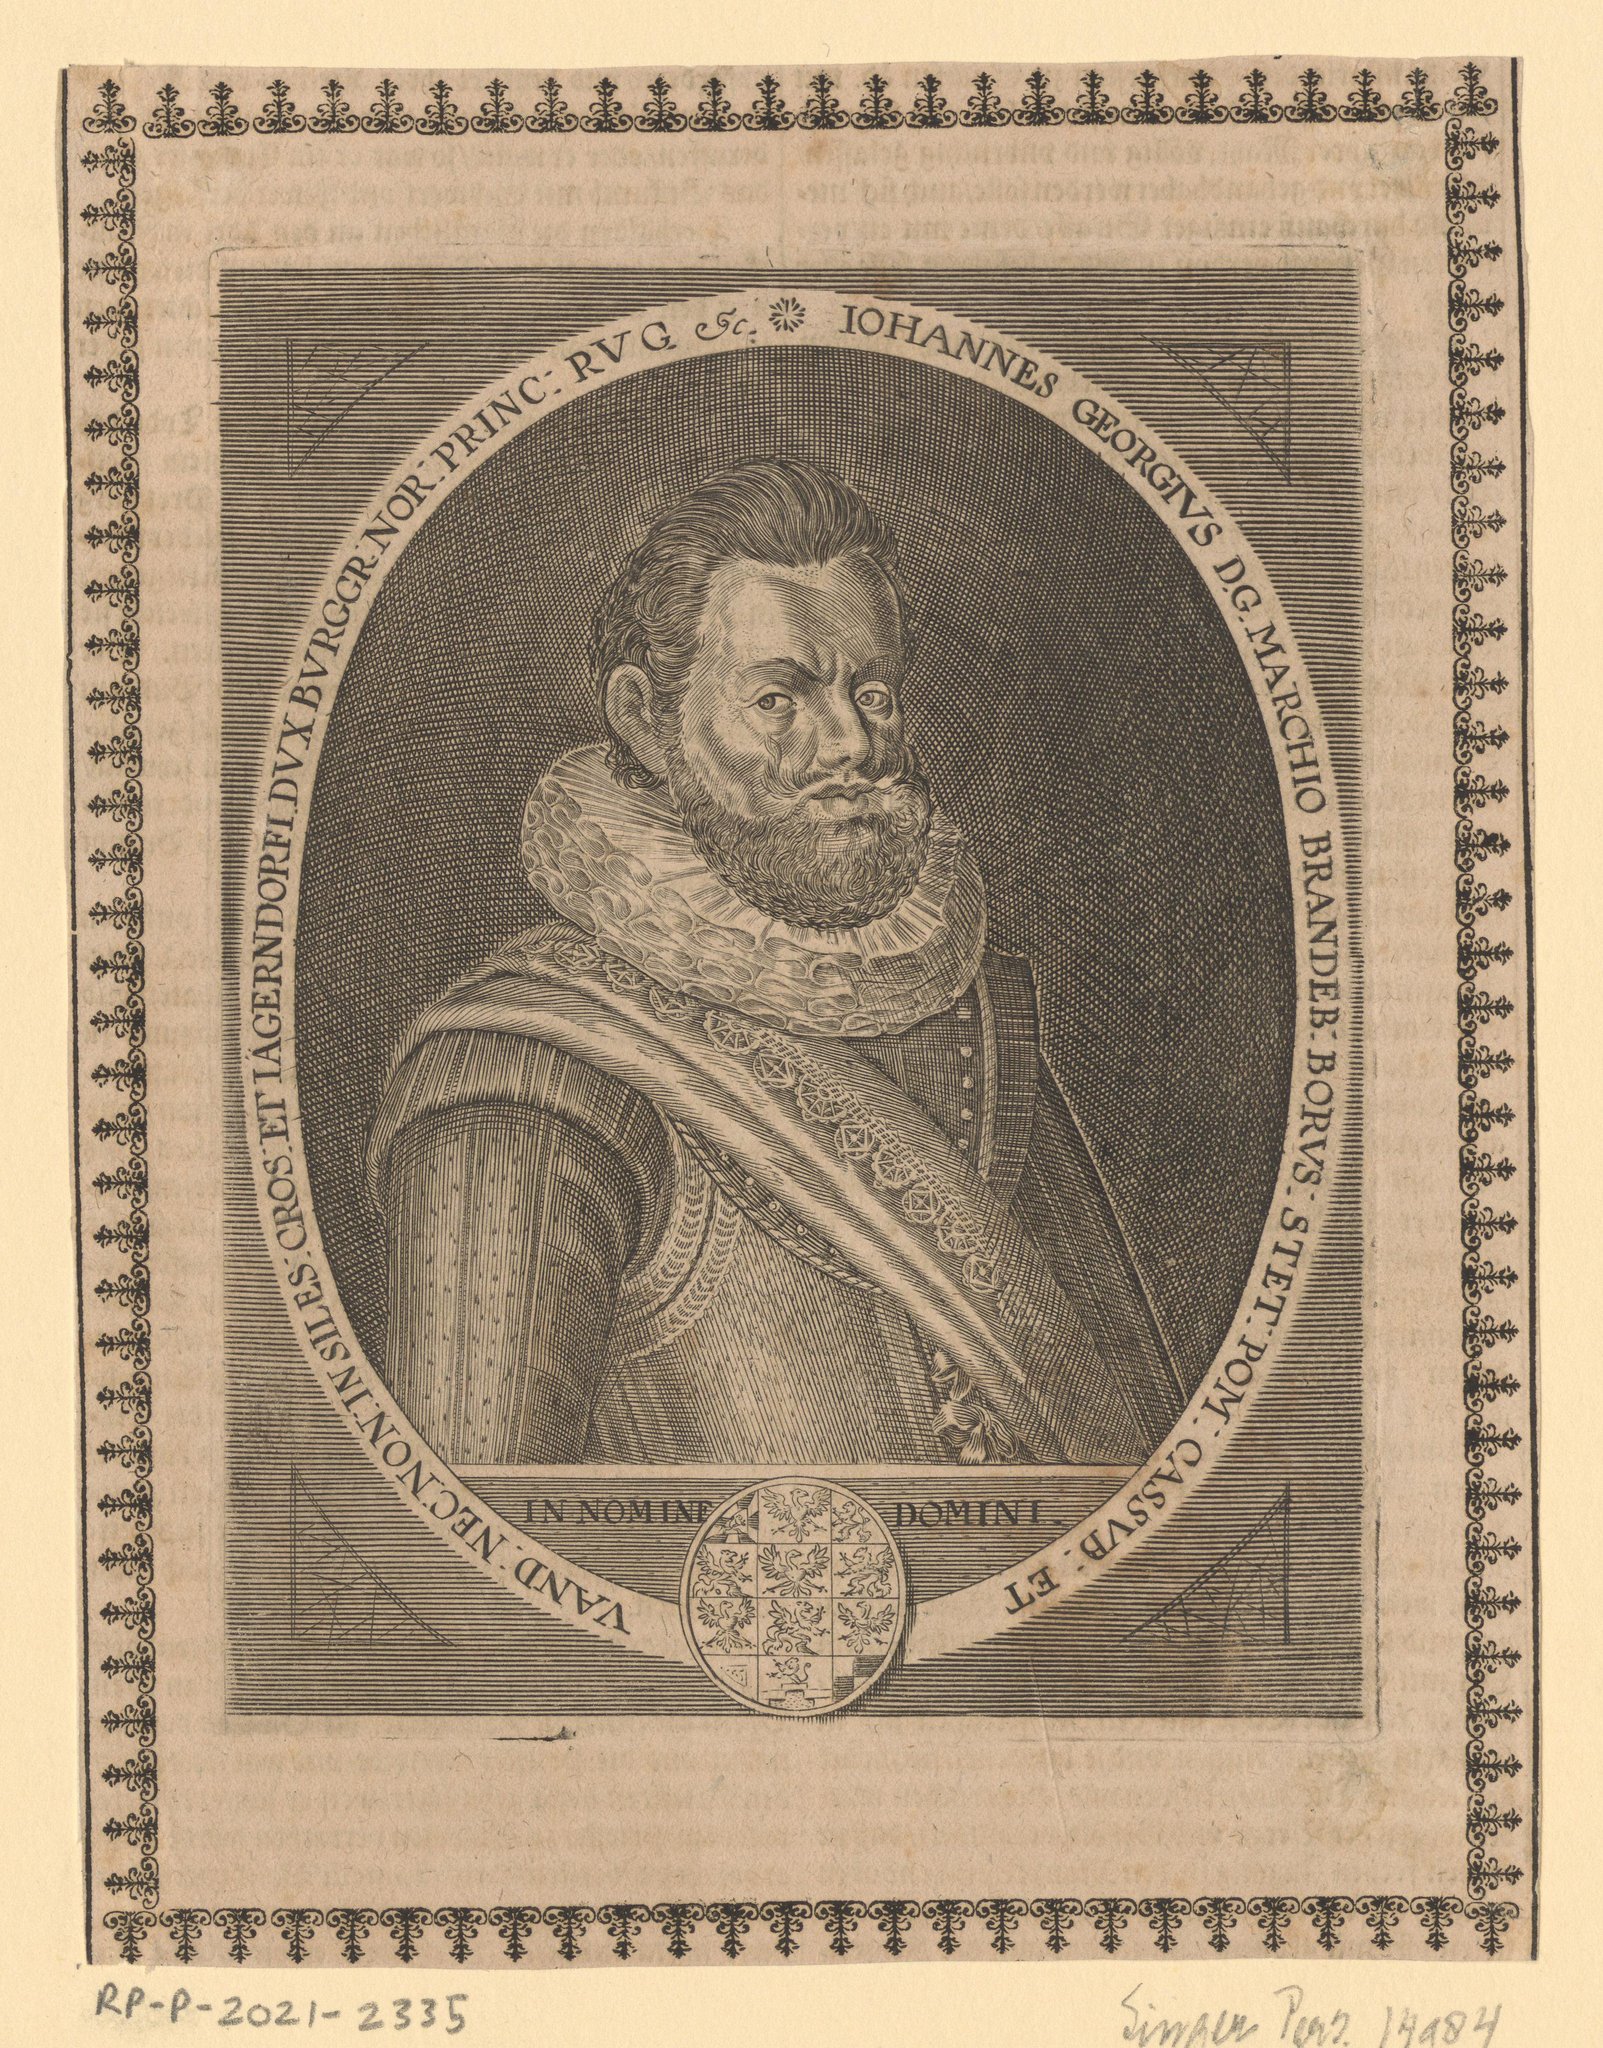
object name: book illustration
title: Portret van graaf Johann Georg von Brandenburg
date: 1641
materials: paper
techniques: engraving, letterpress printing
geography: frankfurt am main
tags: historical persons, ruler, sovereign, armorial bearing, heraldry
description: Prent uit: Helvicus, Nicolaus. Theatrum historiae universalis catholico-protestantium (...). Frankfurt: Johann Gottfried Schönwetters, 1641.